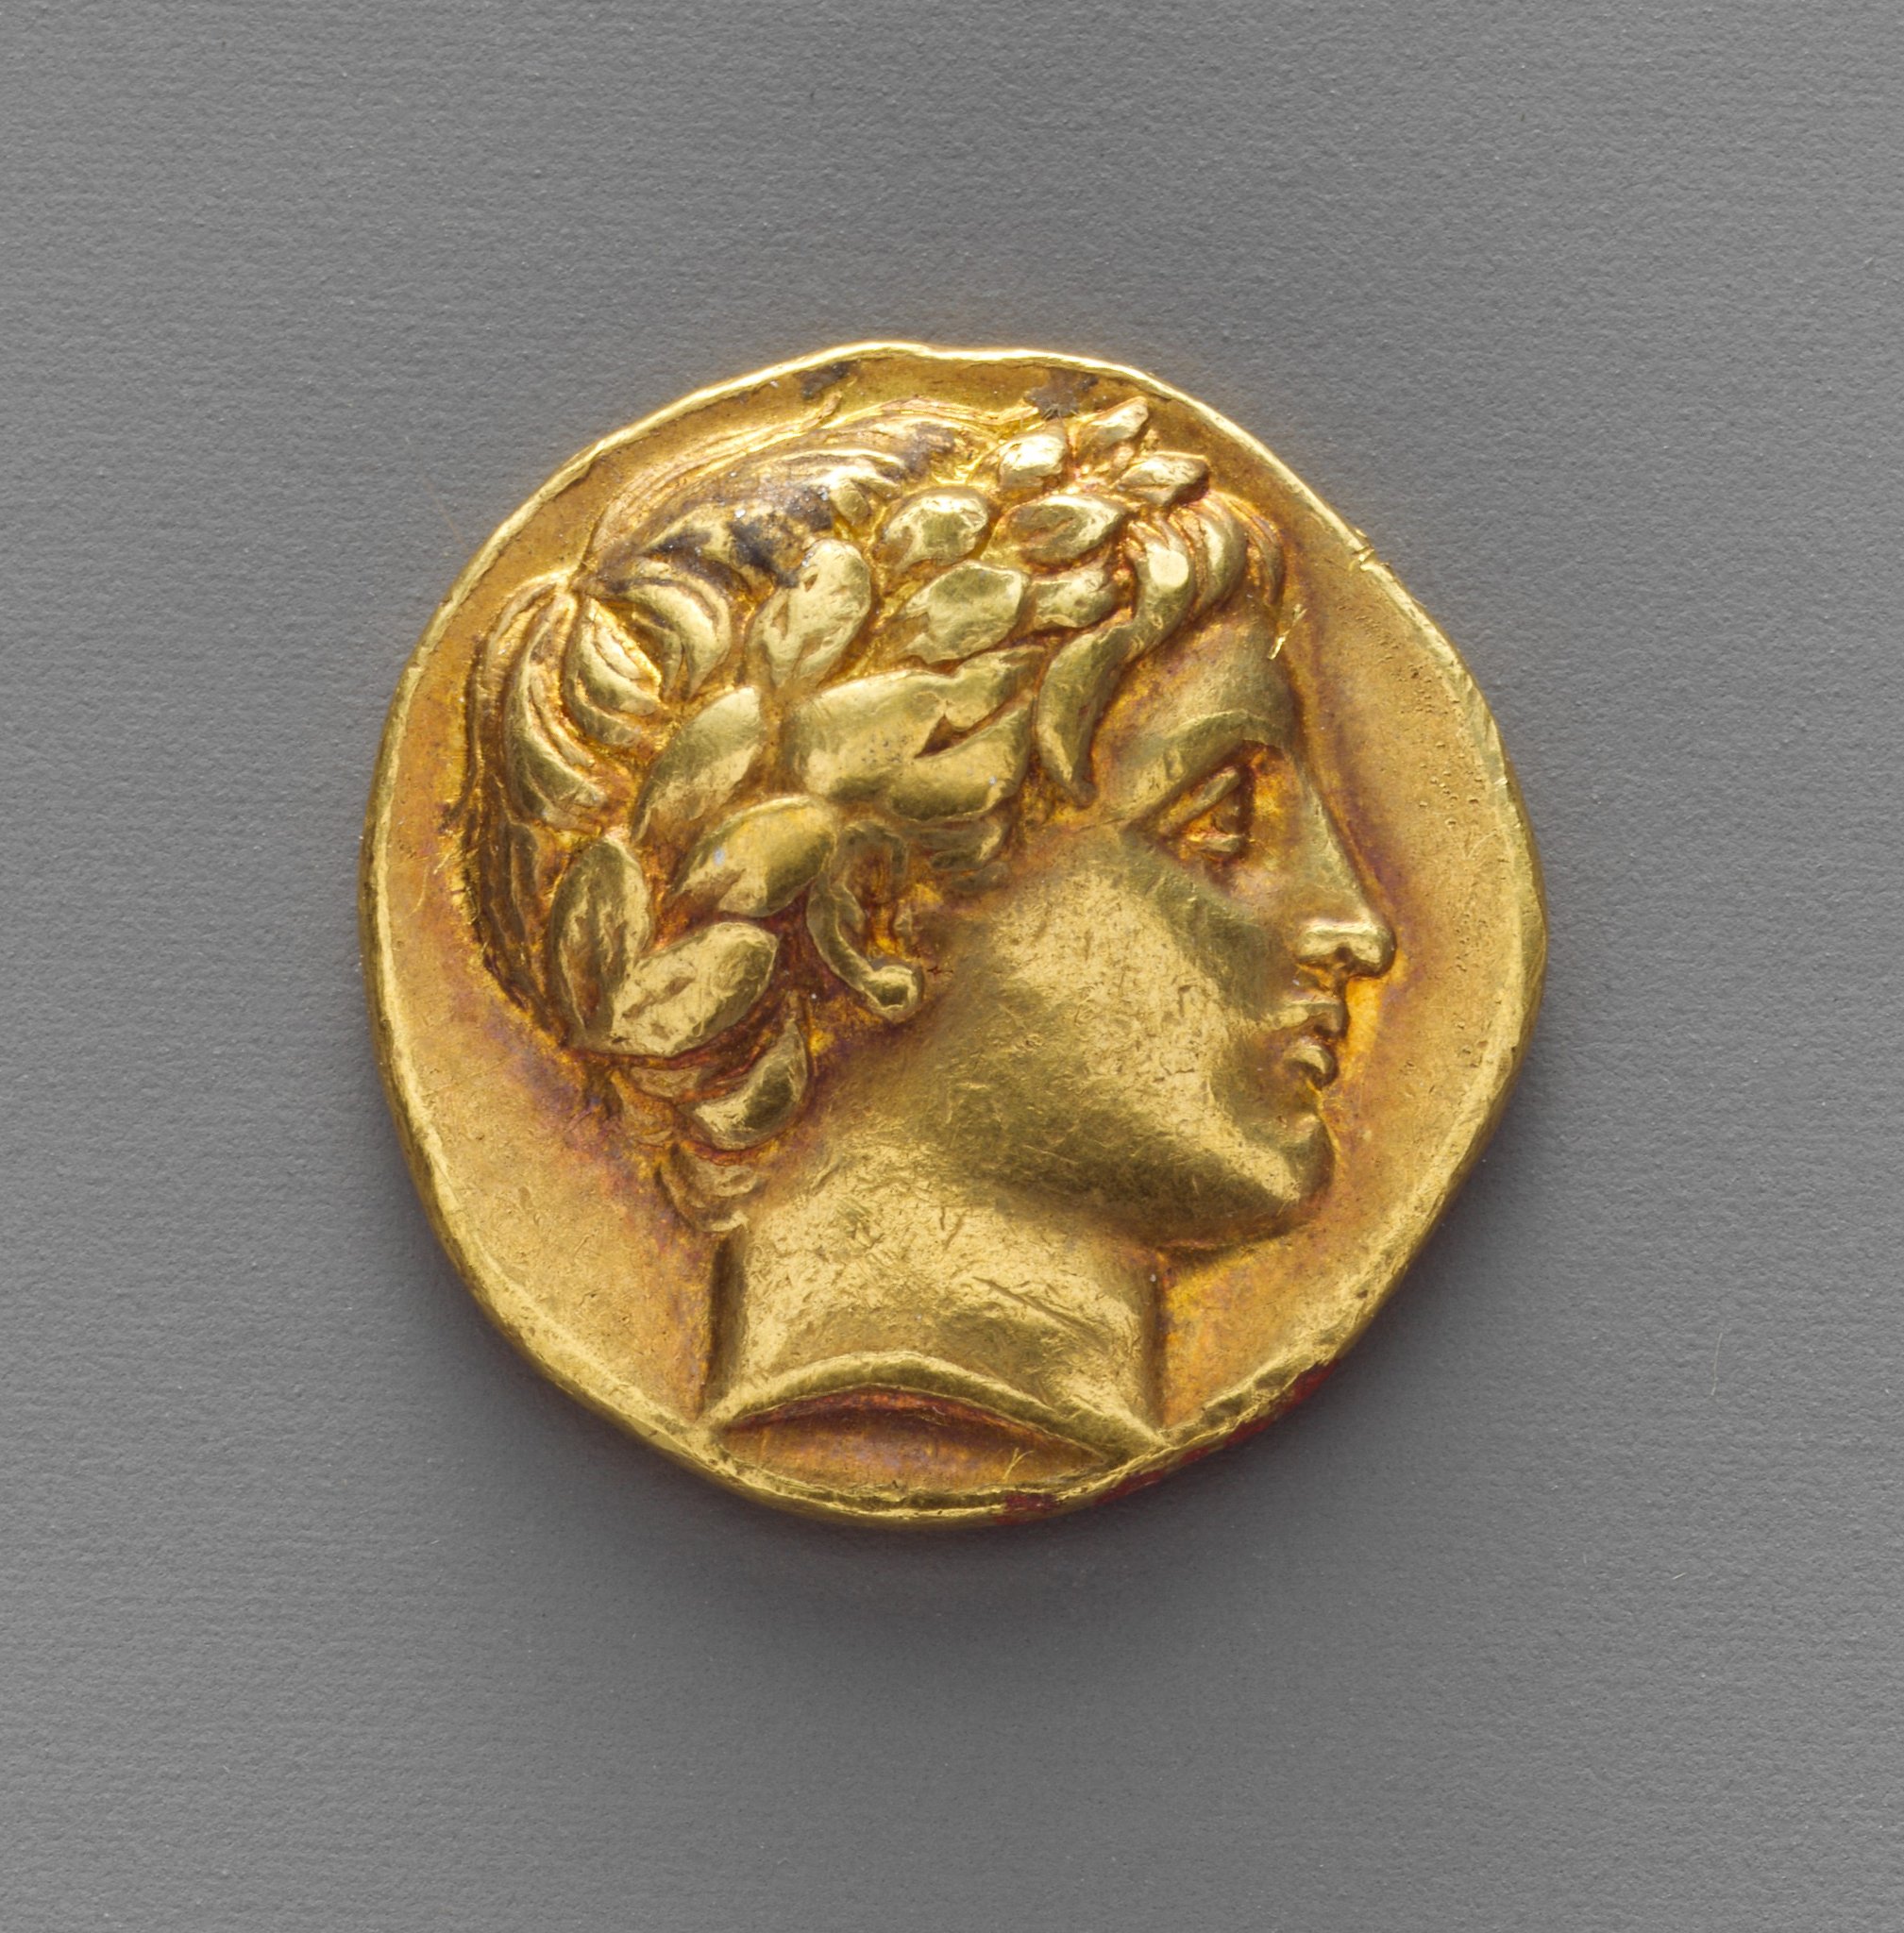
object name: stater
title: Gold stater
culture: greek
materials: gold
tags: alexander the great,profiles,coins